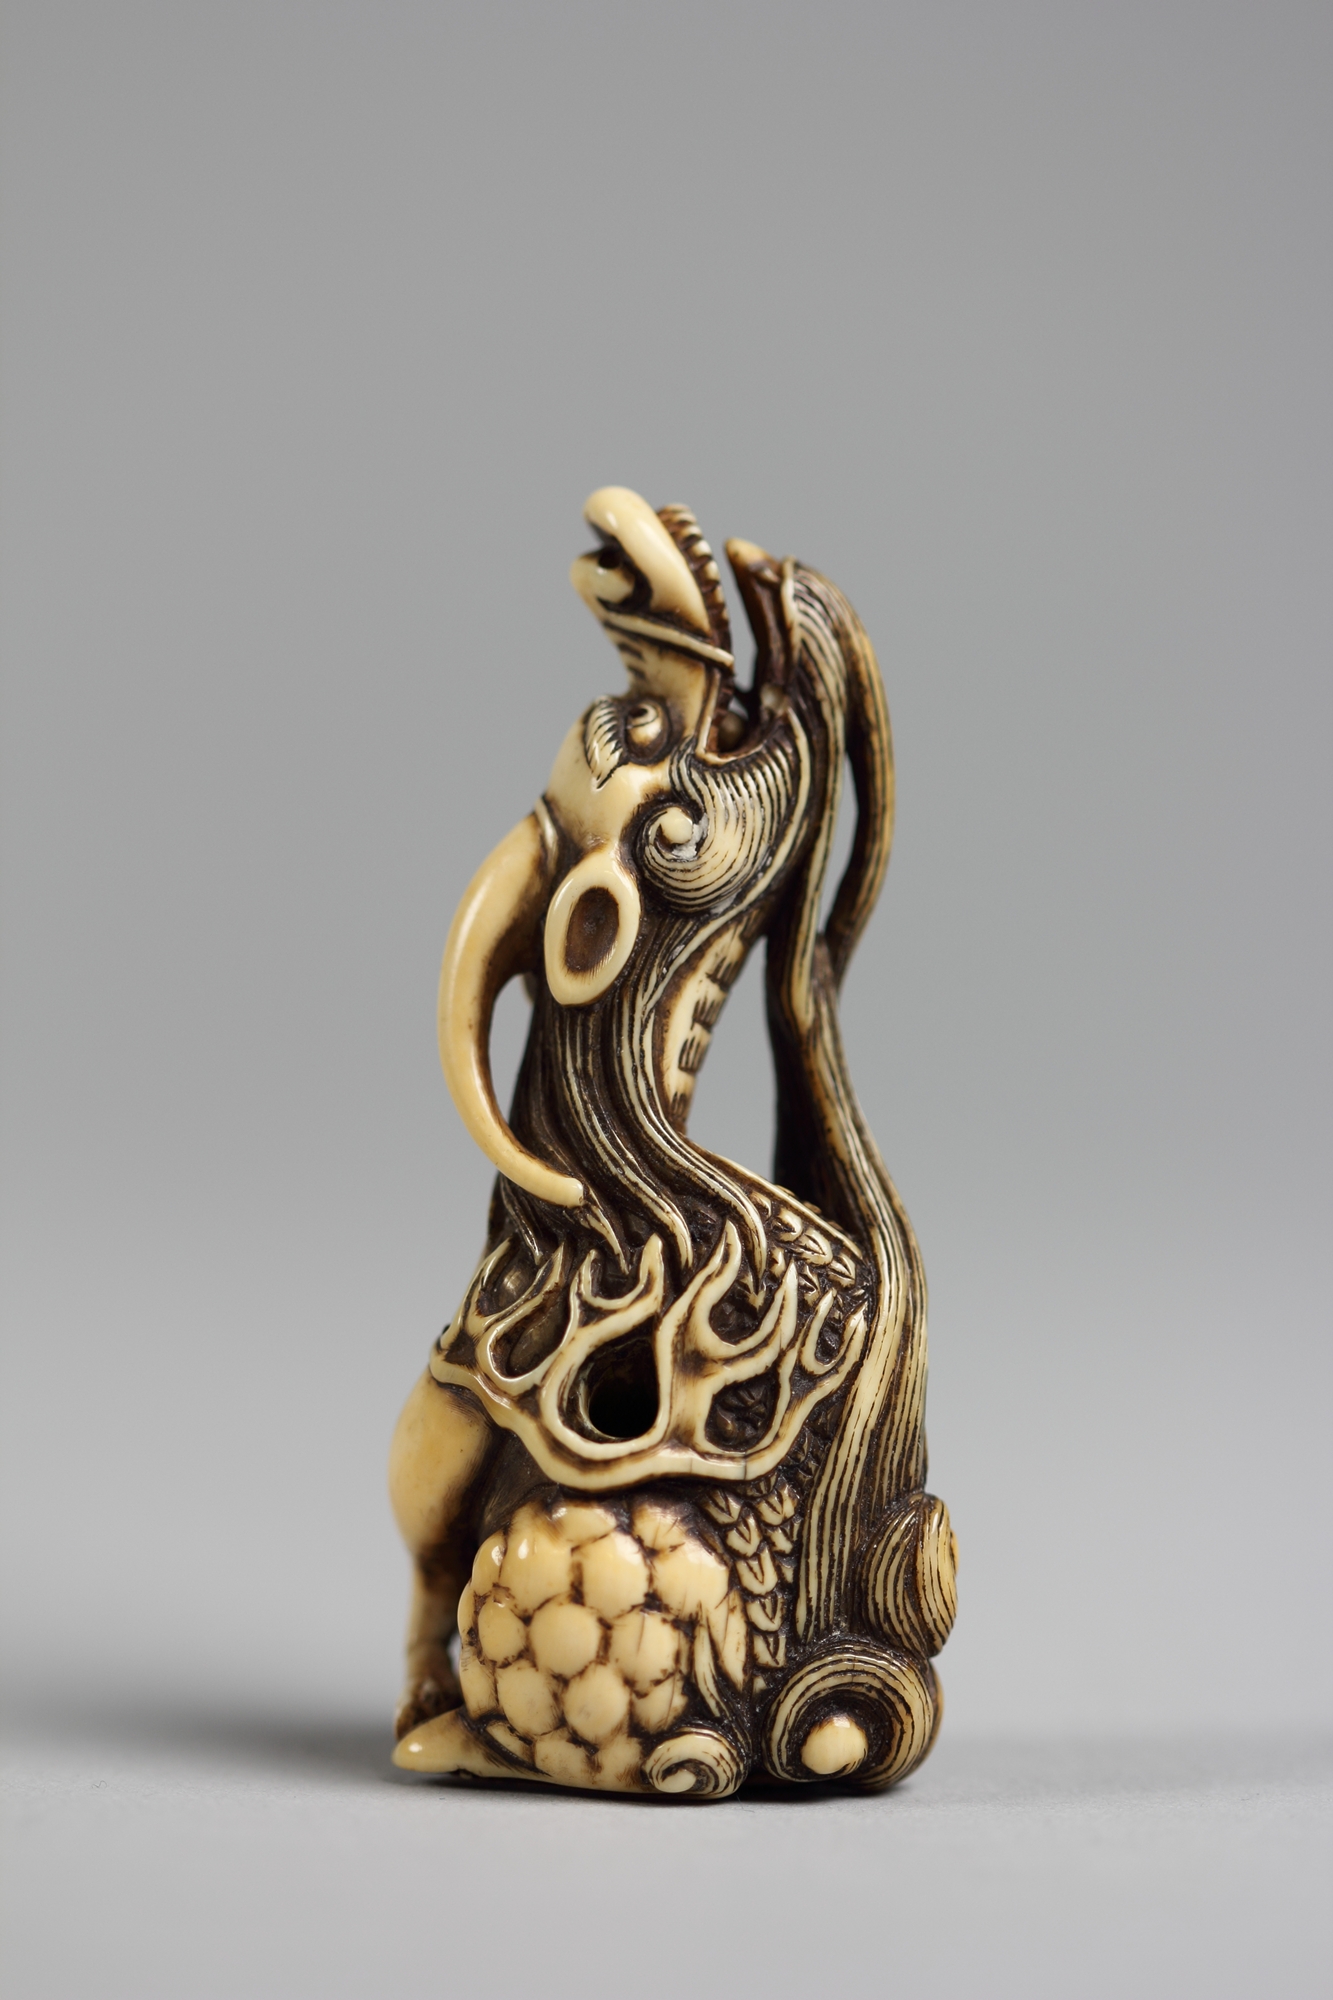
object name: netsuke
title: Kirin (Mythical Chimera)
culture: japanese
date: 1701-1800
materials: ivory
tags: mythical creatures